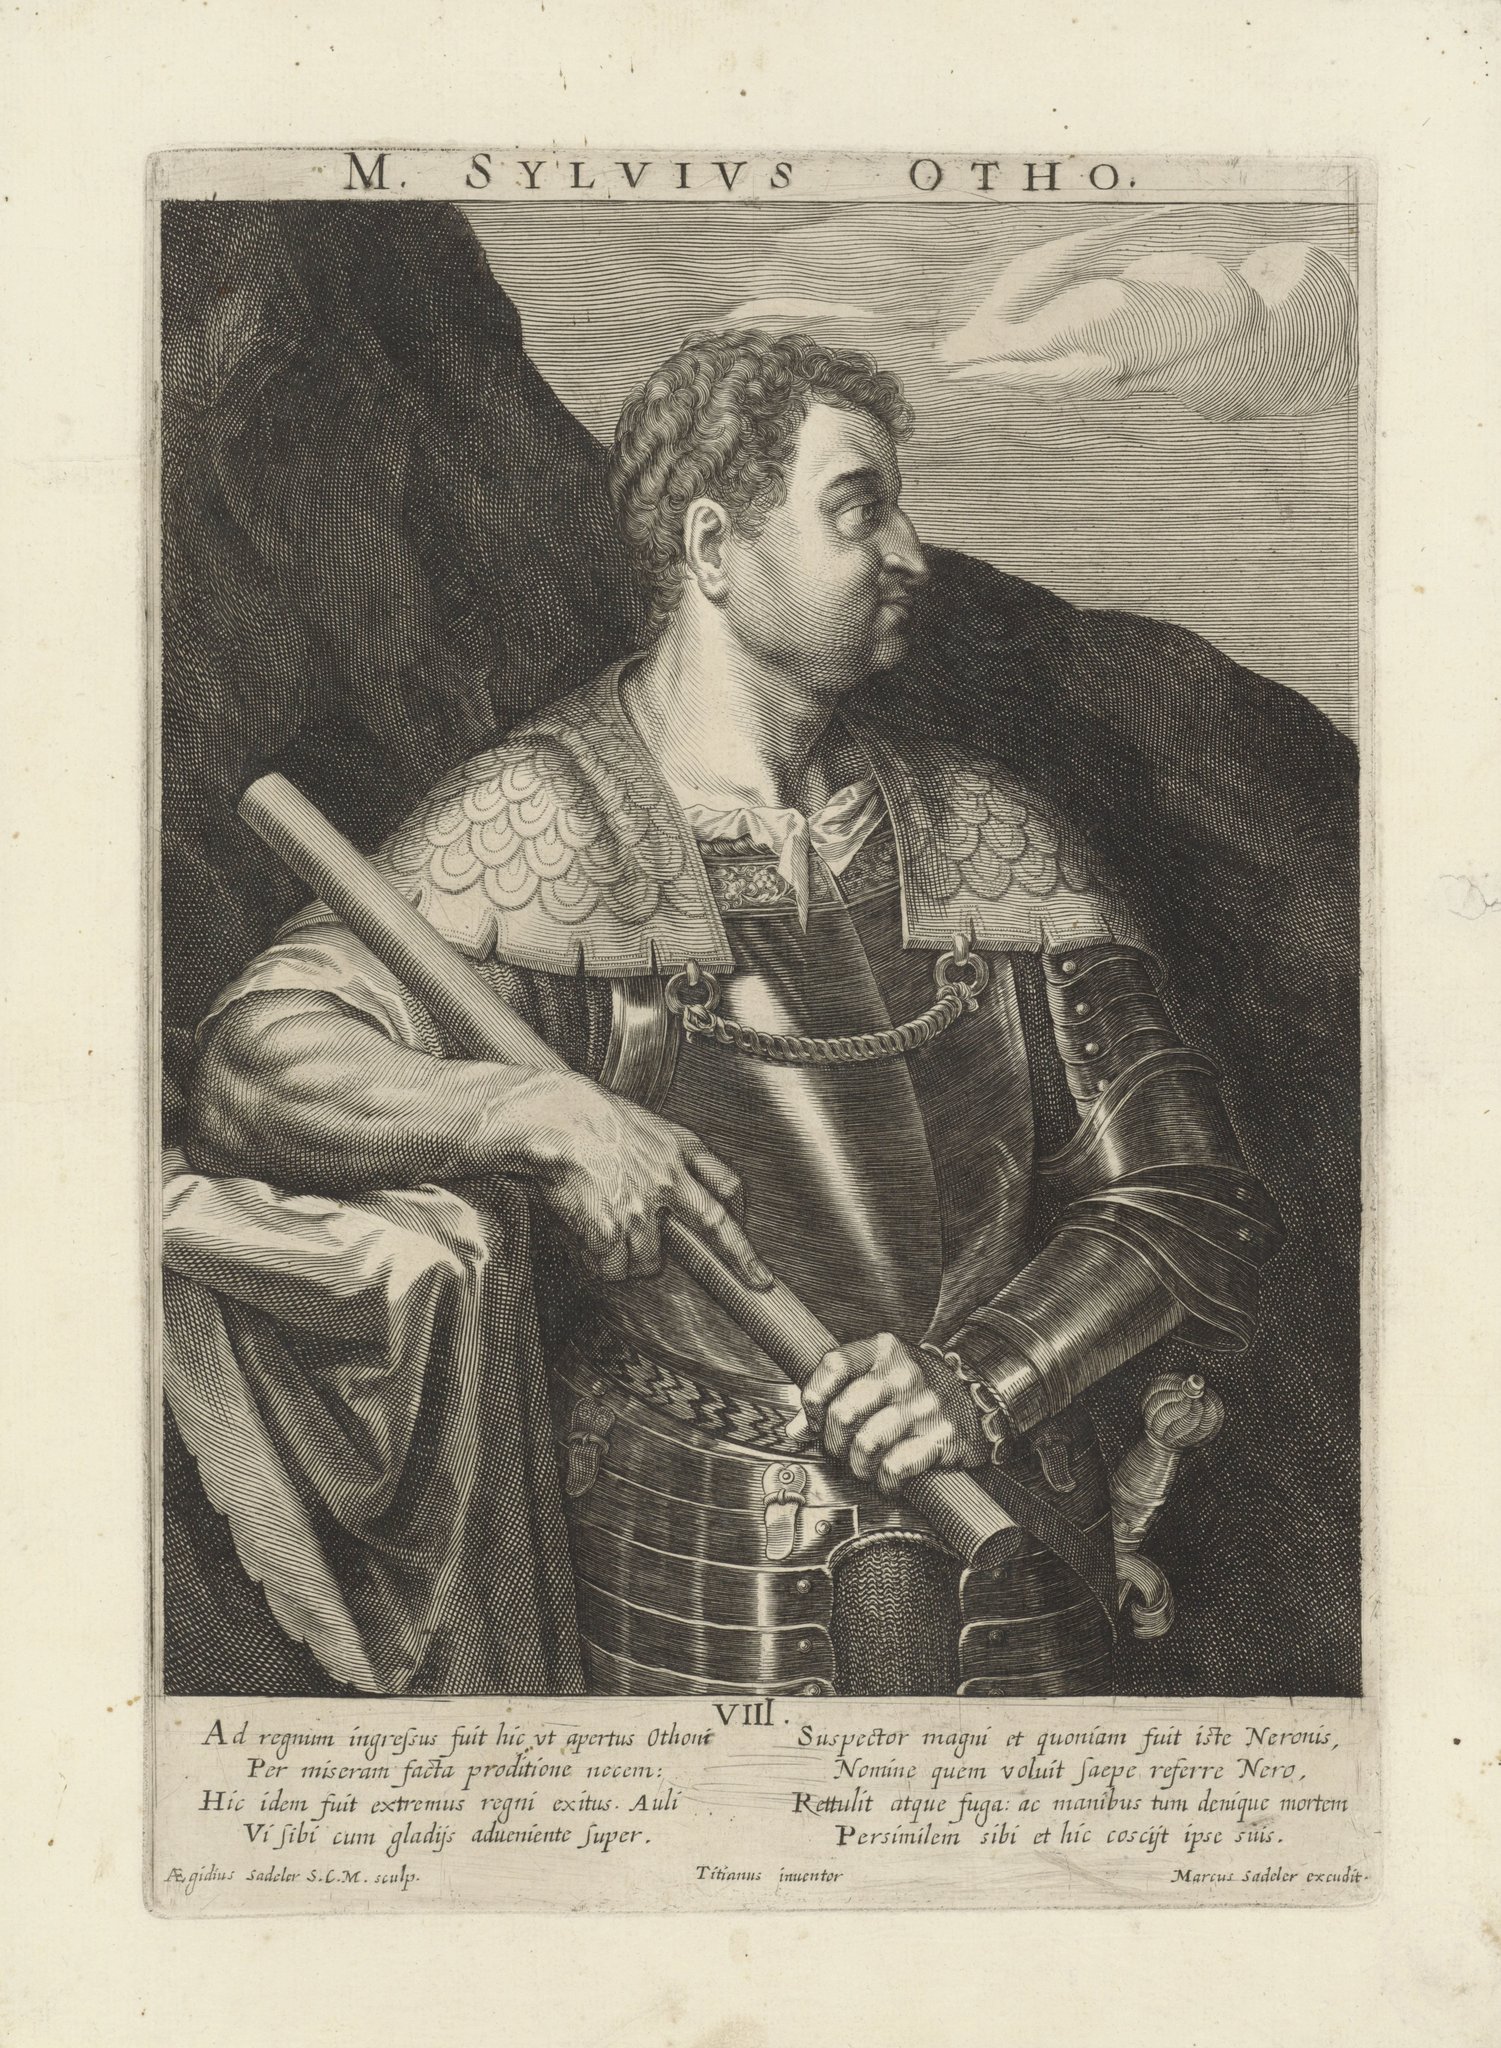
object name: print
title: Portret van keizer Otho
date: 1597-1629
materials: paper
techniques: engraving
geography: prague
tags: ferento, keizer, otho (keizer van het romeinse rijk)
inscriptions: collector's mark: Lugt 240